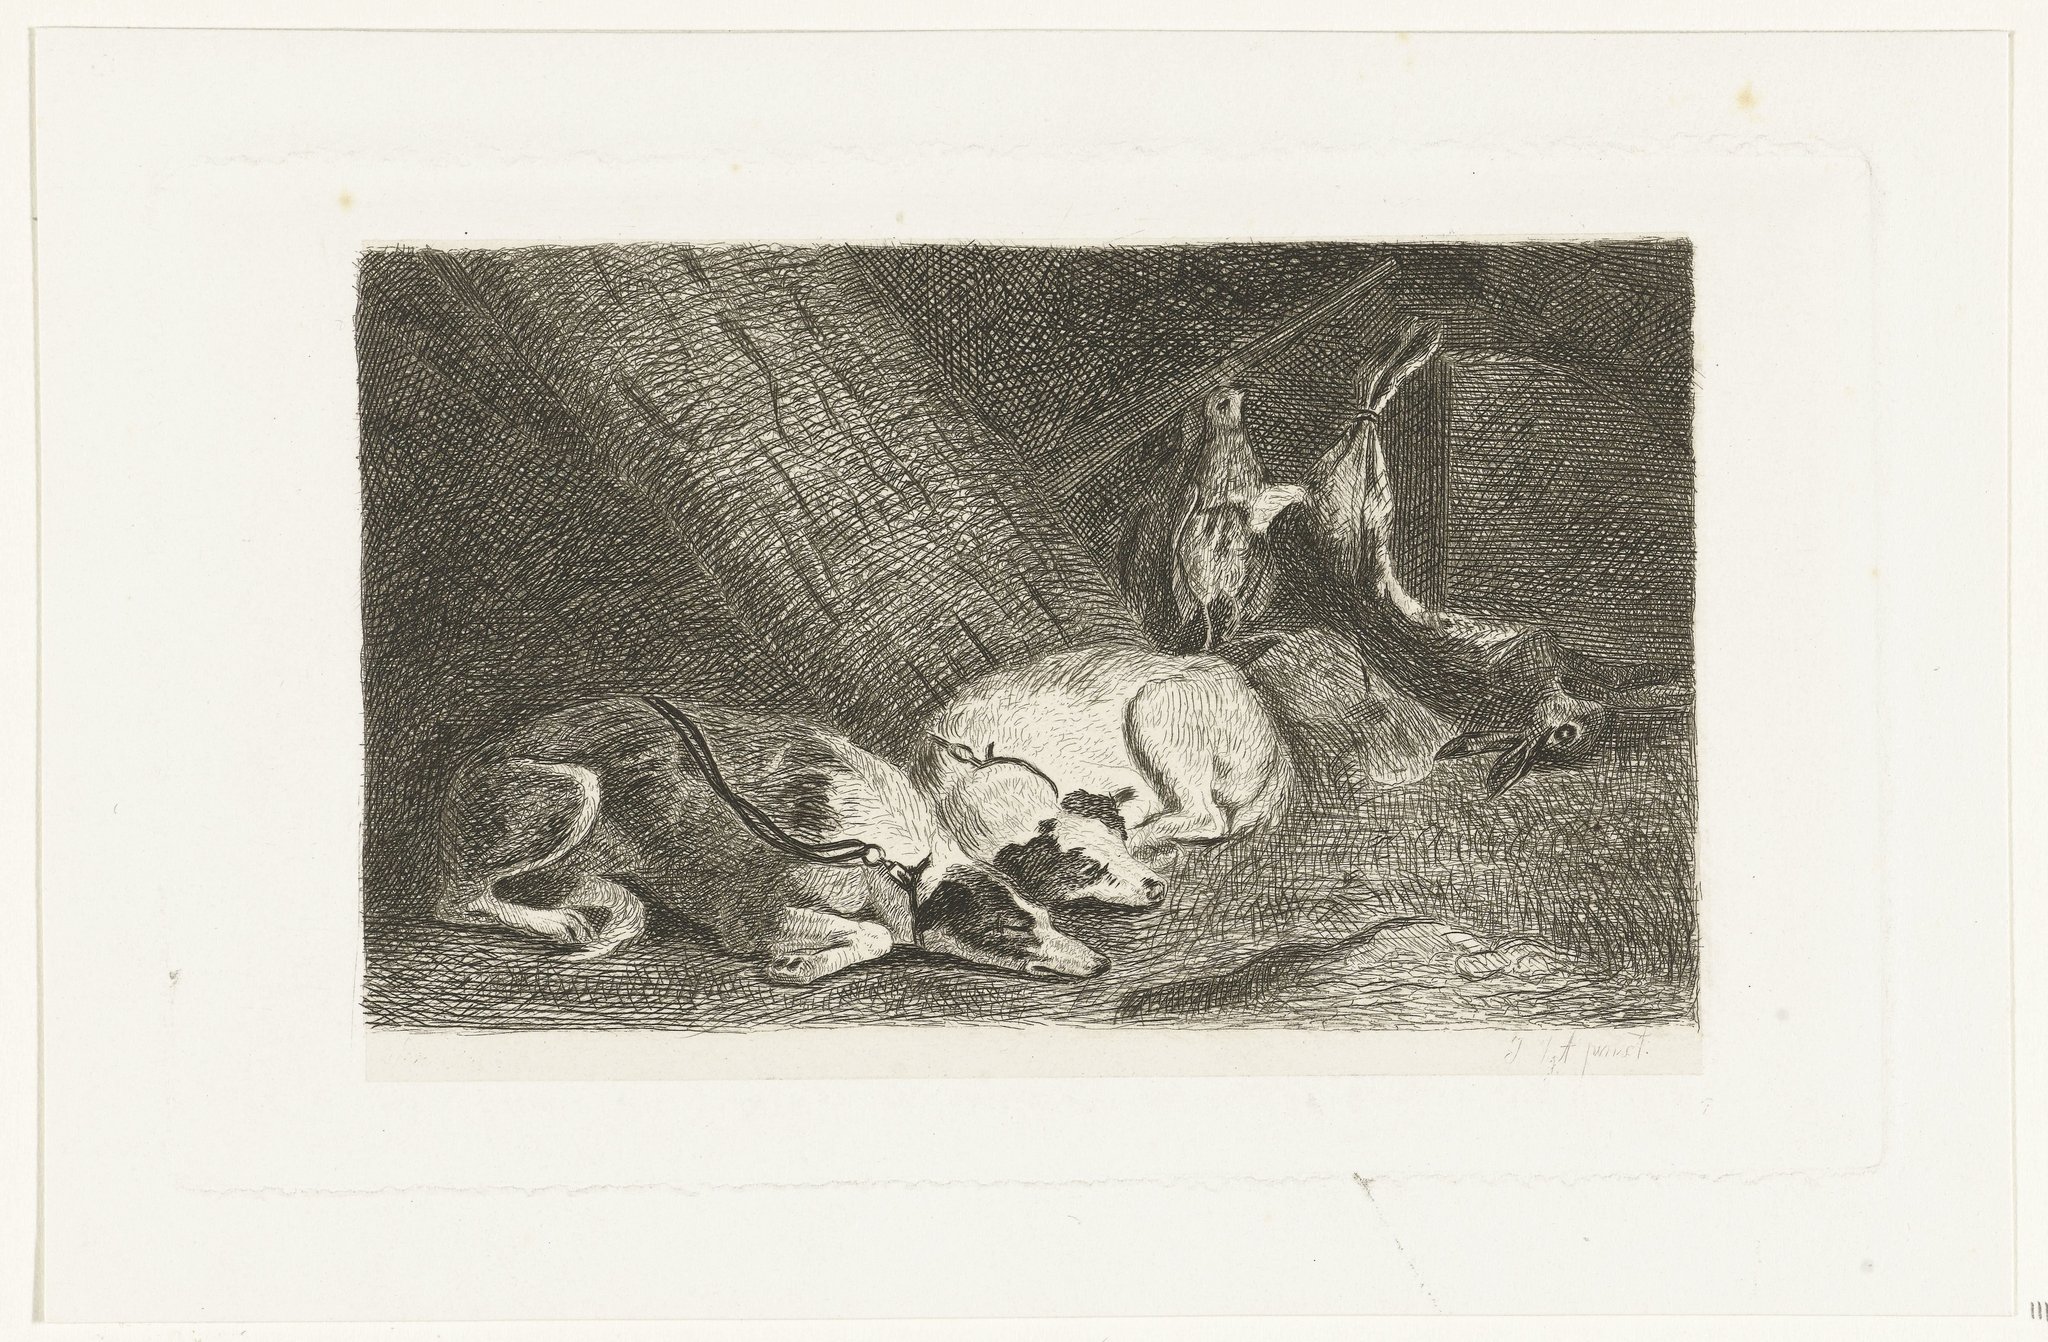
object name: print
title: Twee honden rusten bij de jachtbuit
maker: jan cassiers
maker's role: print maker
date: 1700-1800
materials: paper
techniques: etching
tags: hunting dogs beside the spoils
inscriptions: collector's mark: Lugt 2228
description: Twee honden liggen al slapend onder een boom. Naast hen de jachtbuit: een konijn en een patrijs.